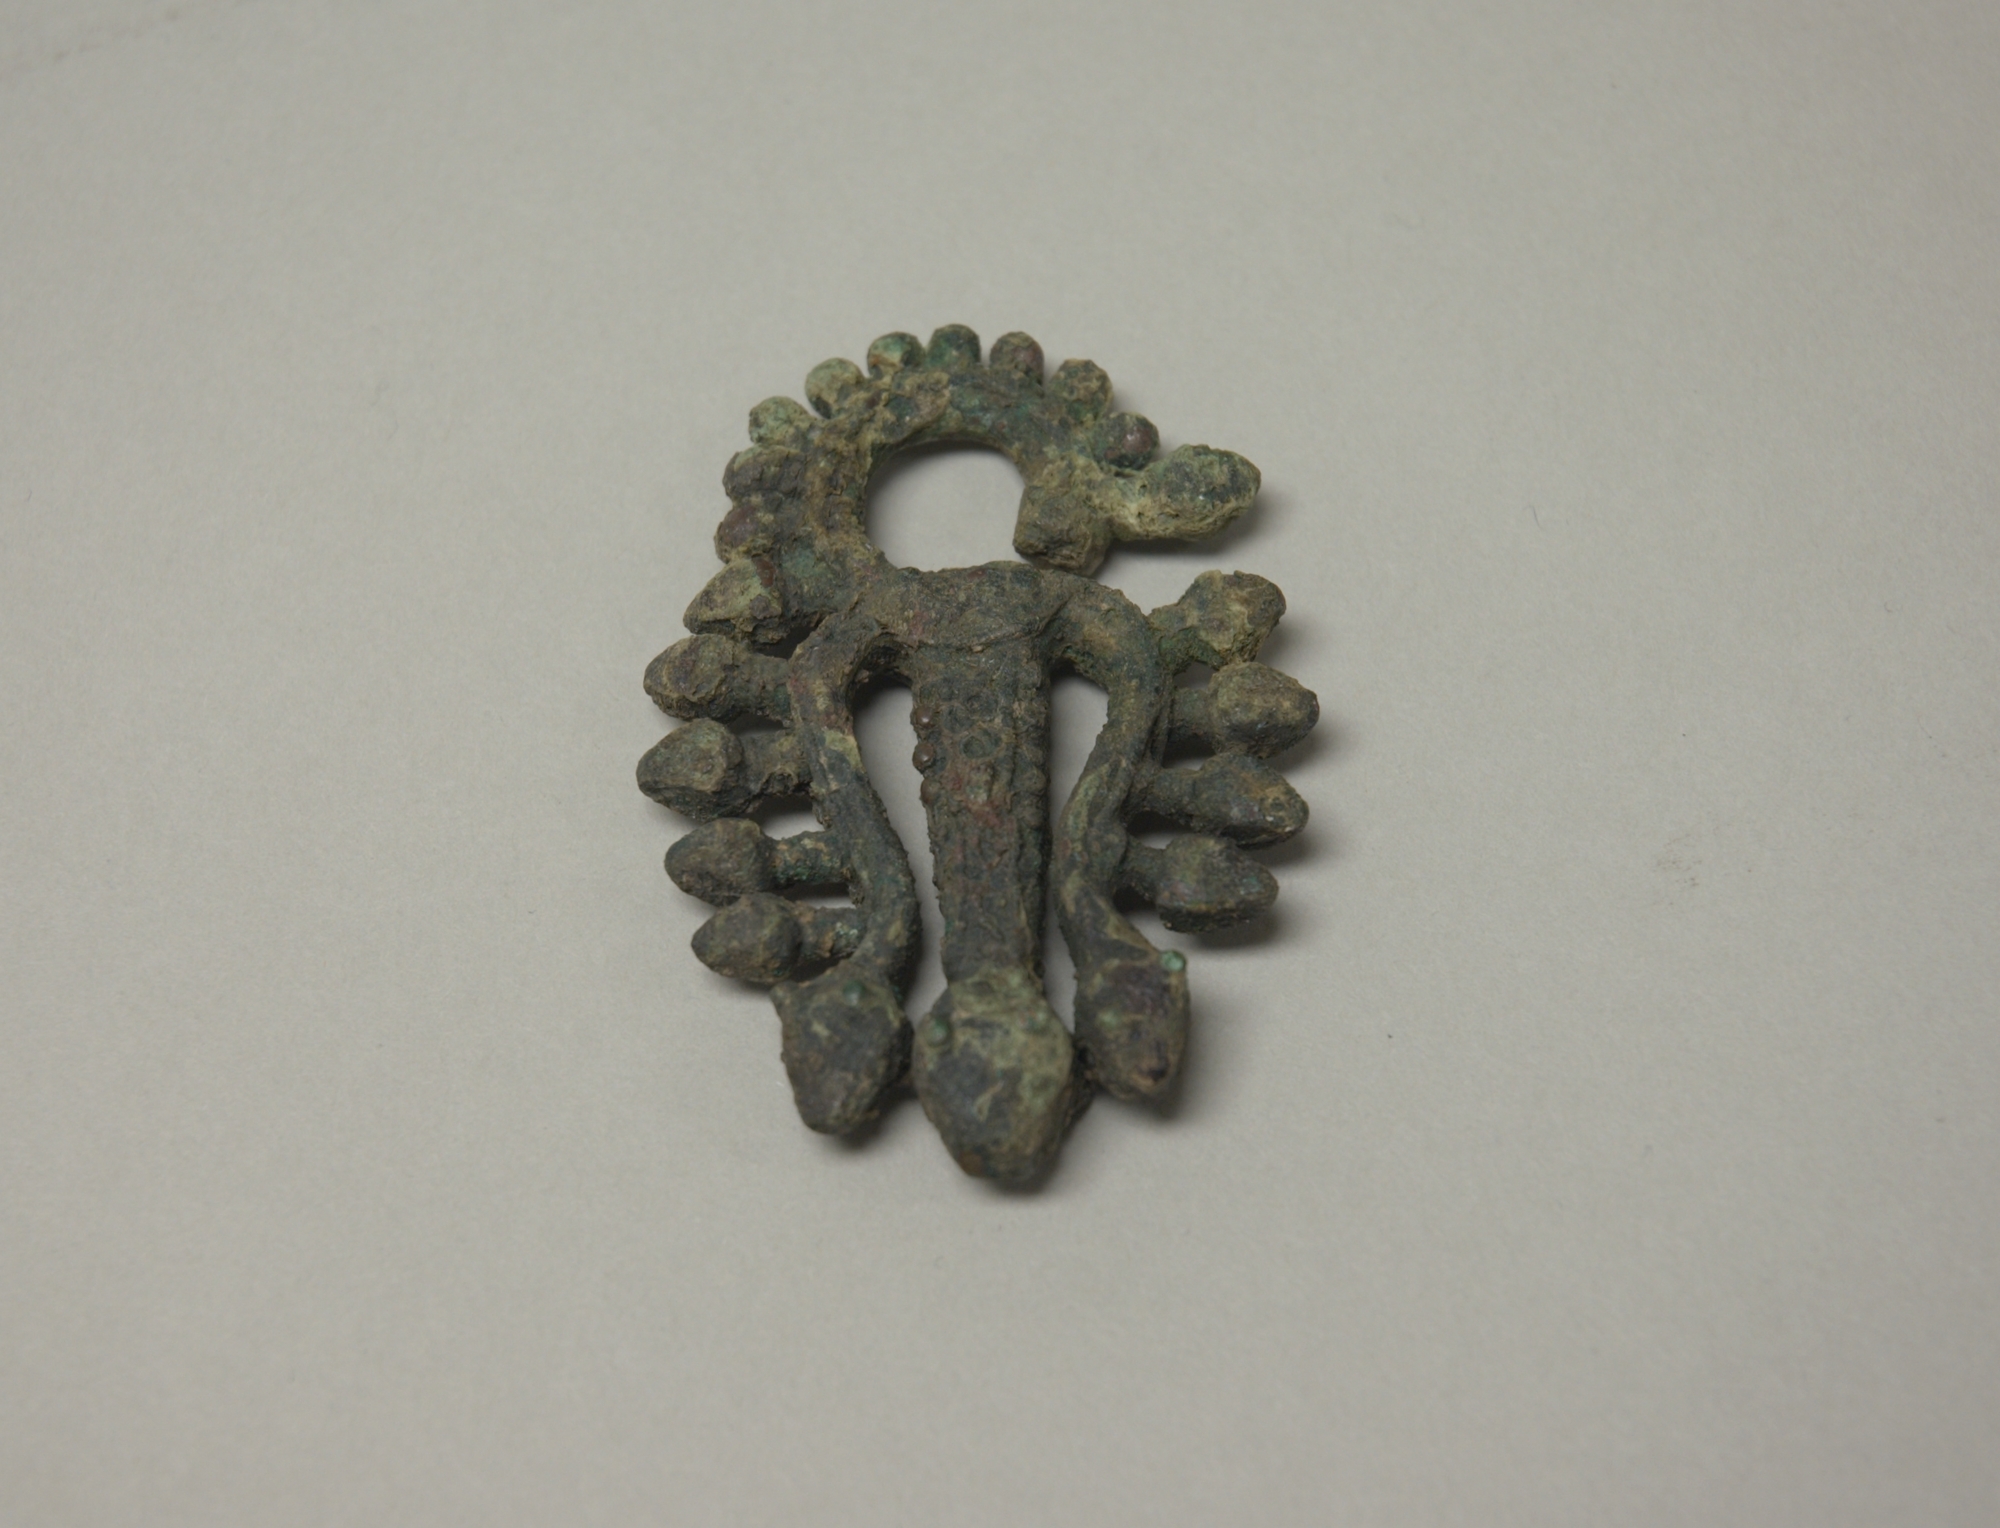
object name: earring with pendant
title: One of a Pair of Ear Pendants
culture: vietnamese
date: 500 BCE-300 CE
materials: bronze